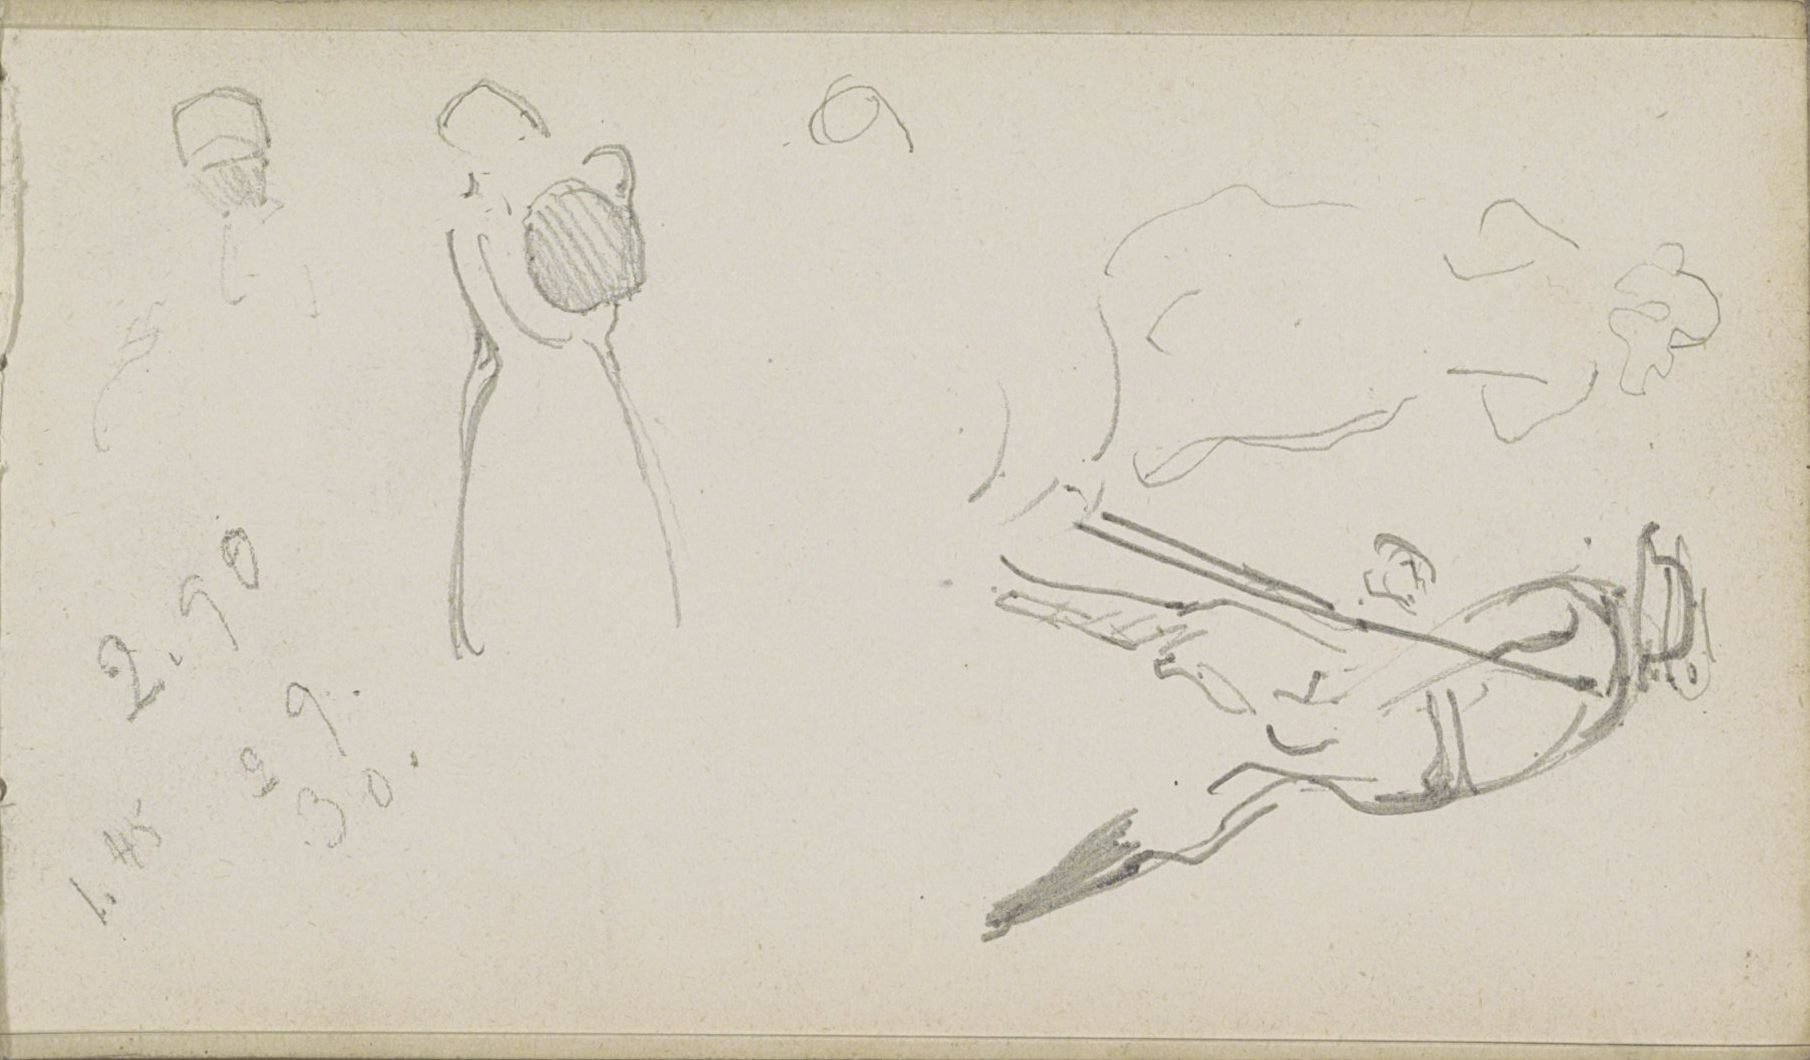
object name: sketchbook leaf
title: Man en vrouwen in Marker klederdracht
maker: george clausen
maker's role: draughtsman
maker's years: 1852-1912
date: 1875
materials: paper, pencil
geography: marken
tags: adult woman, adult man, folk costume, regional costume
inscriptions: annotation: ‘2.90/ 1.45/ 29./ 30.’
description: Blad 19 recto uit een schetsboek met 46 bladen.